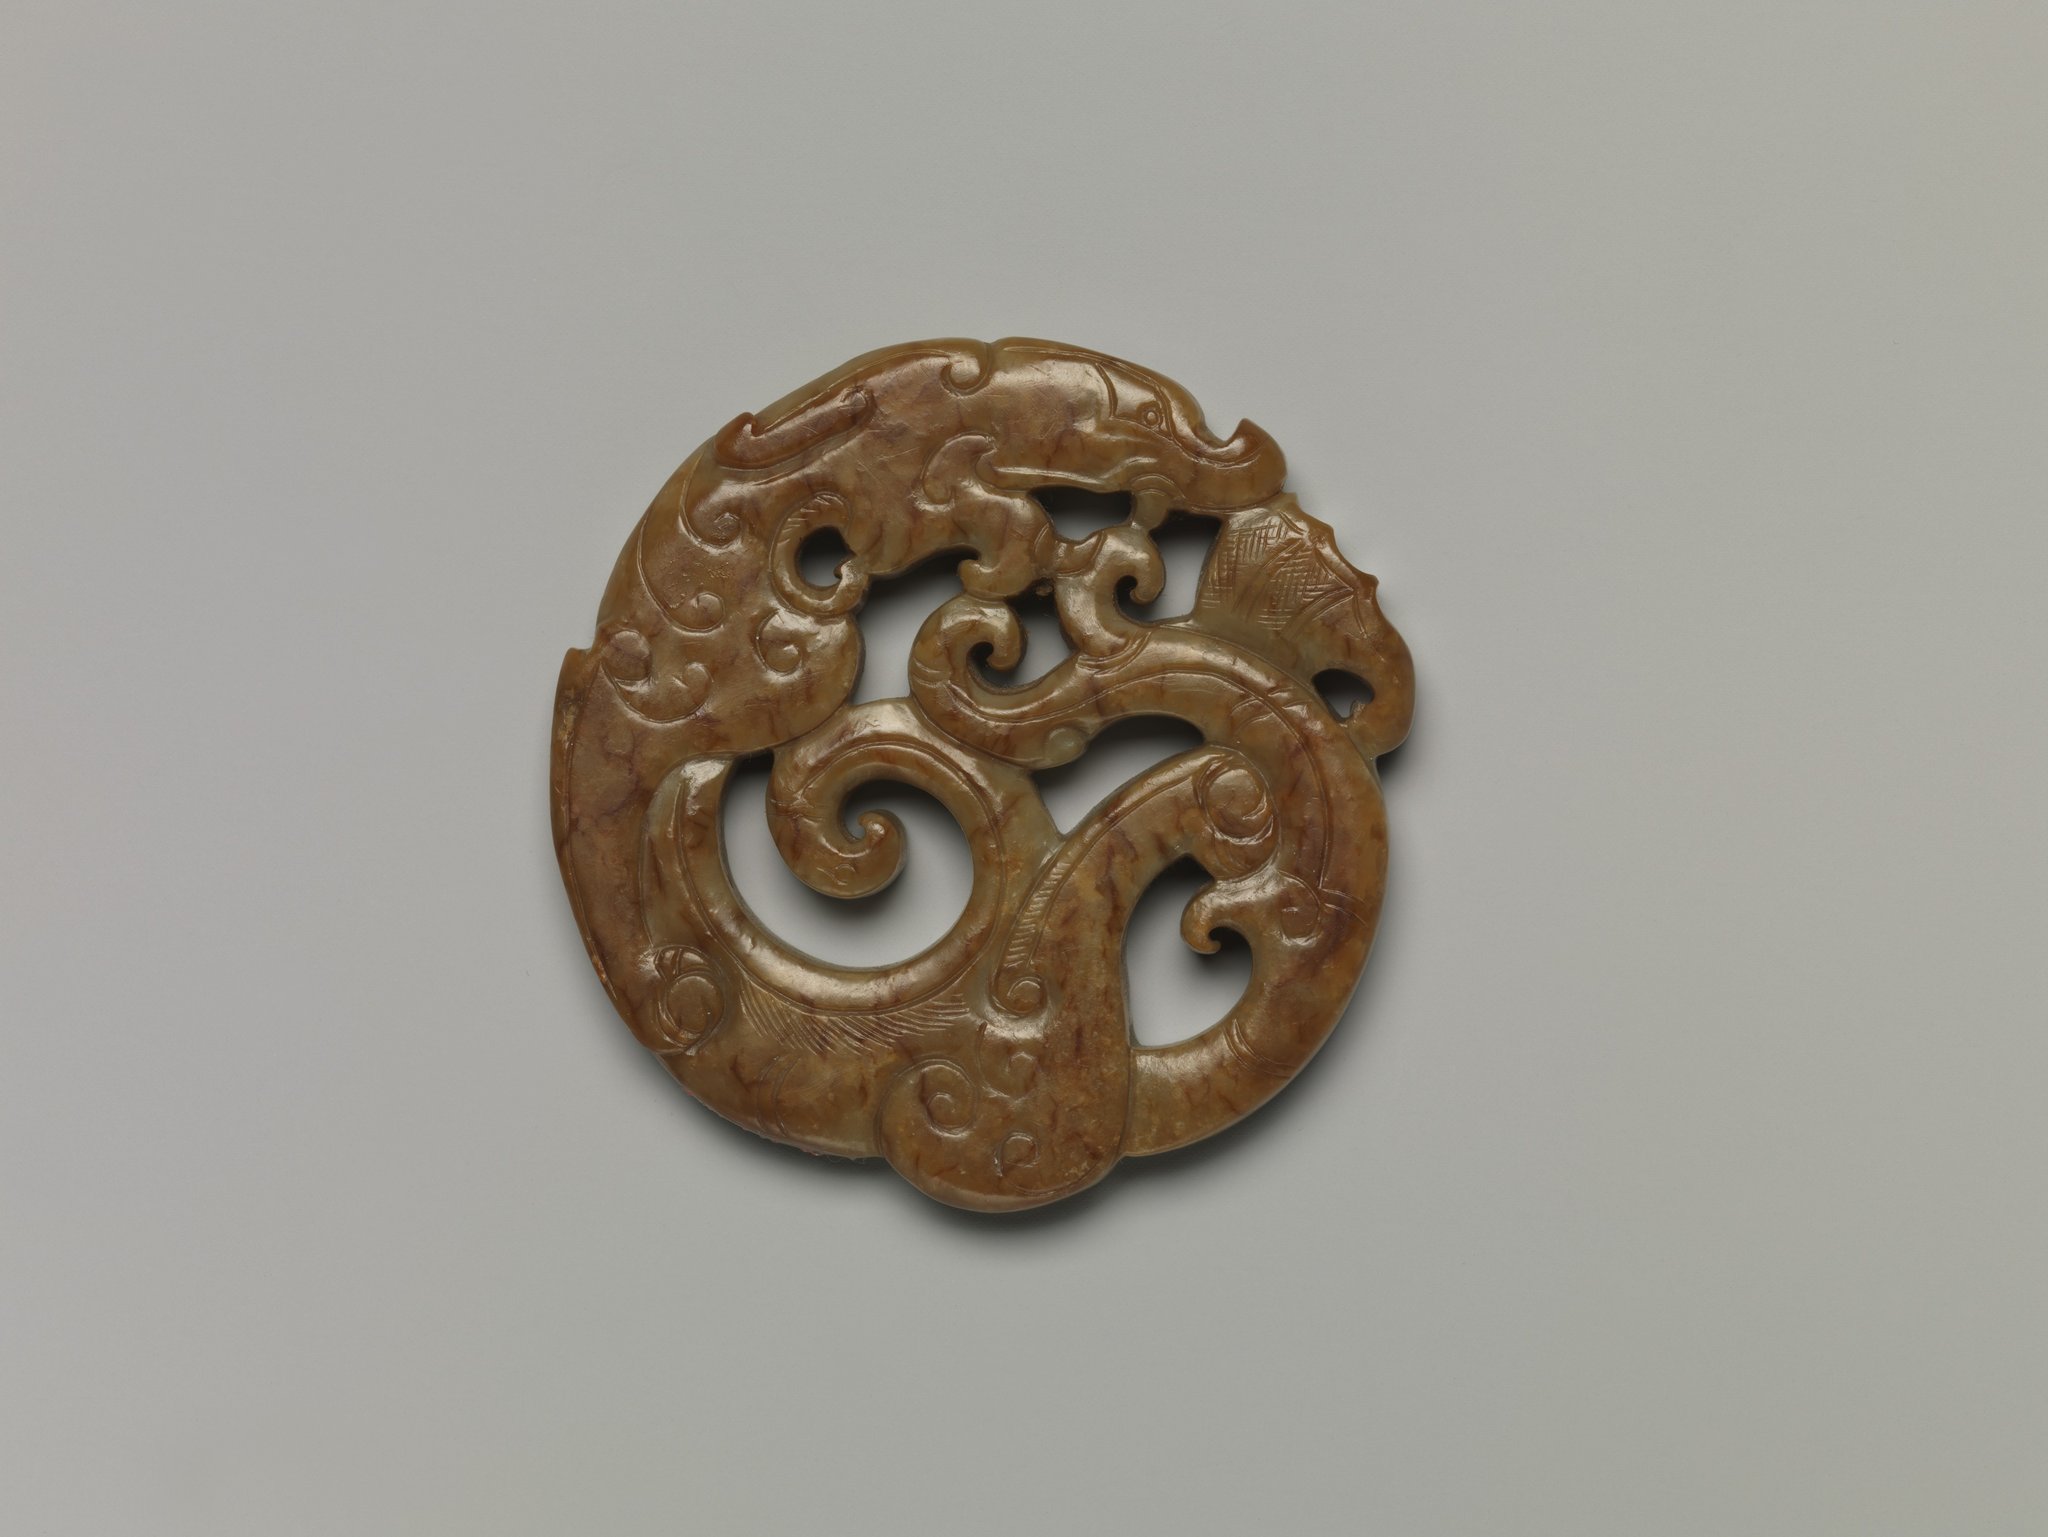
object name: plaque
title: Circular Plaque with Design of a Fantastic Animal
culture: chinese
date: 1644-1911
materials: jade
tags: animals